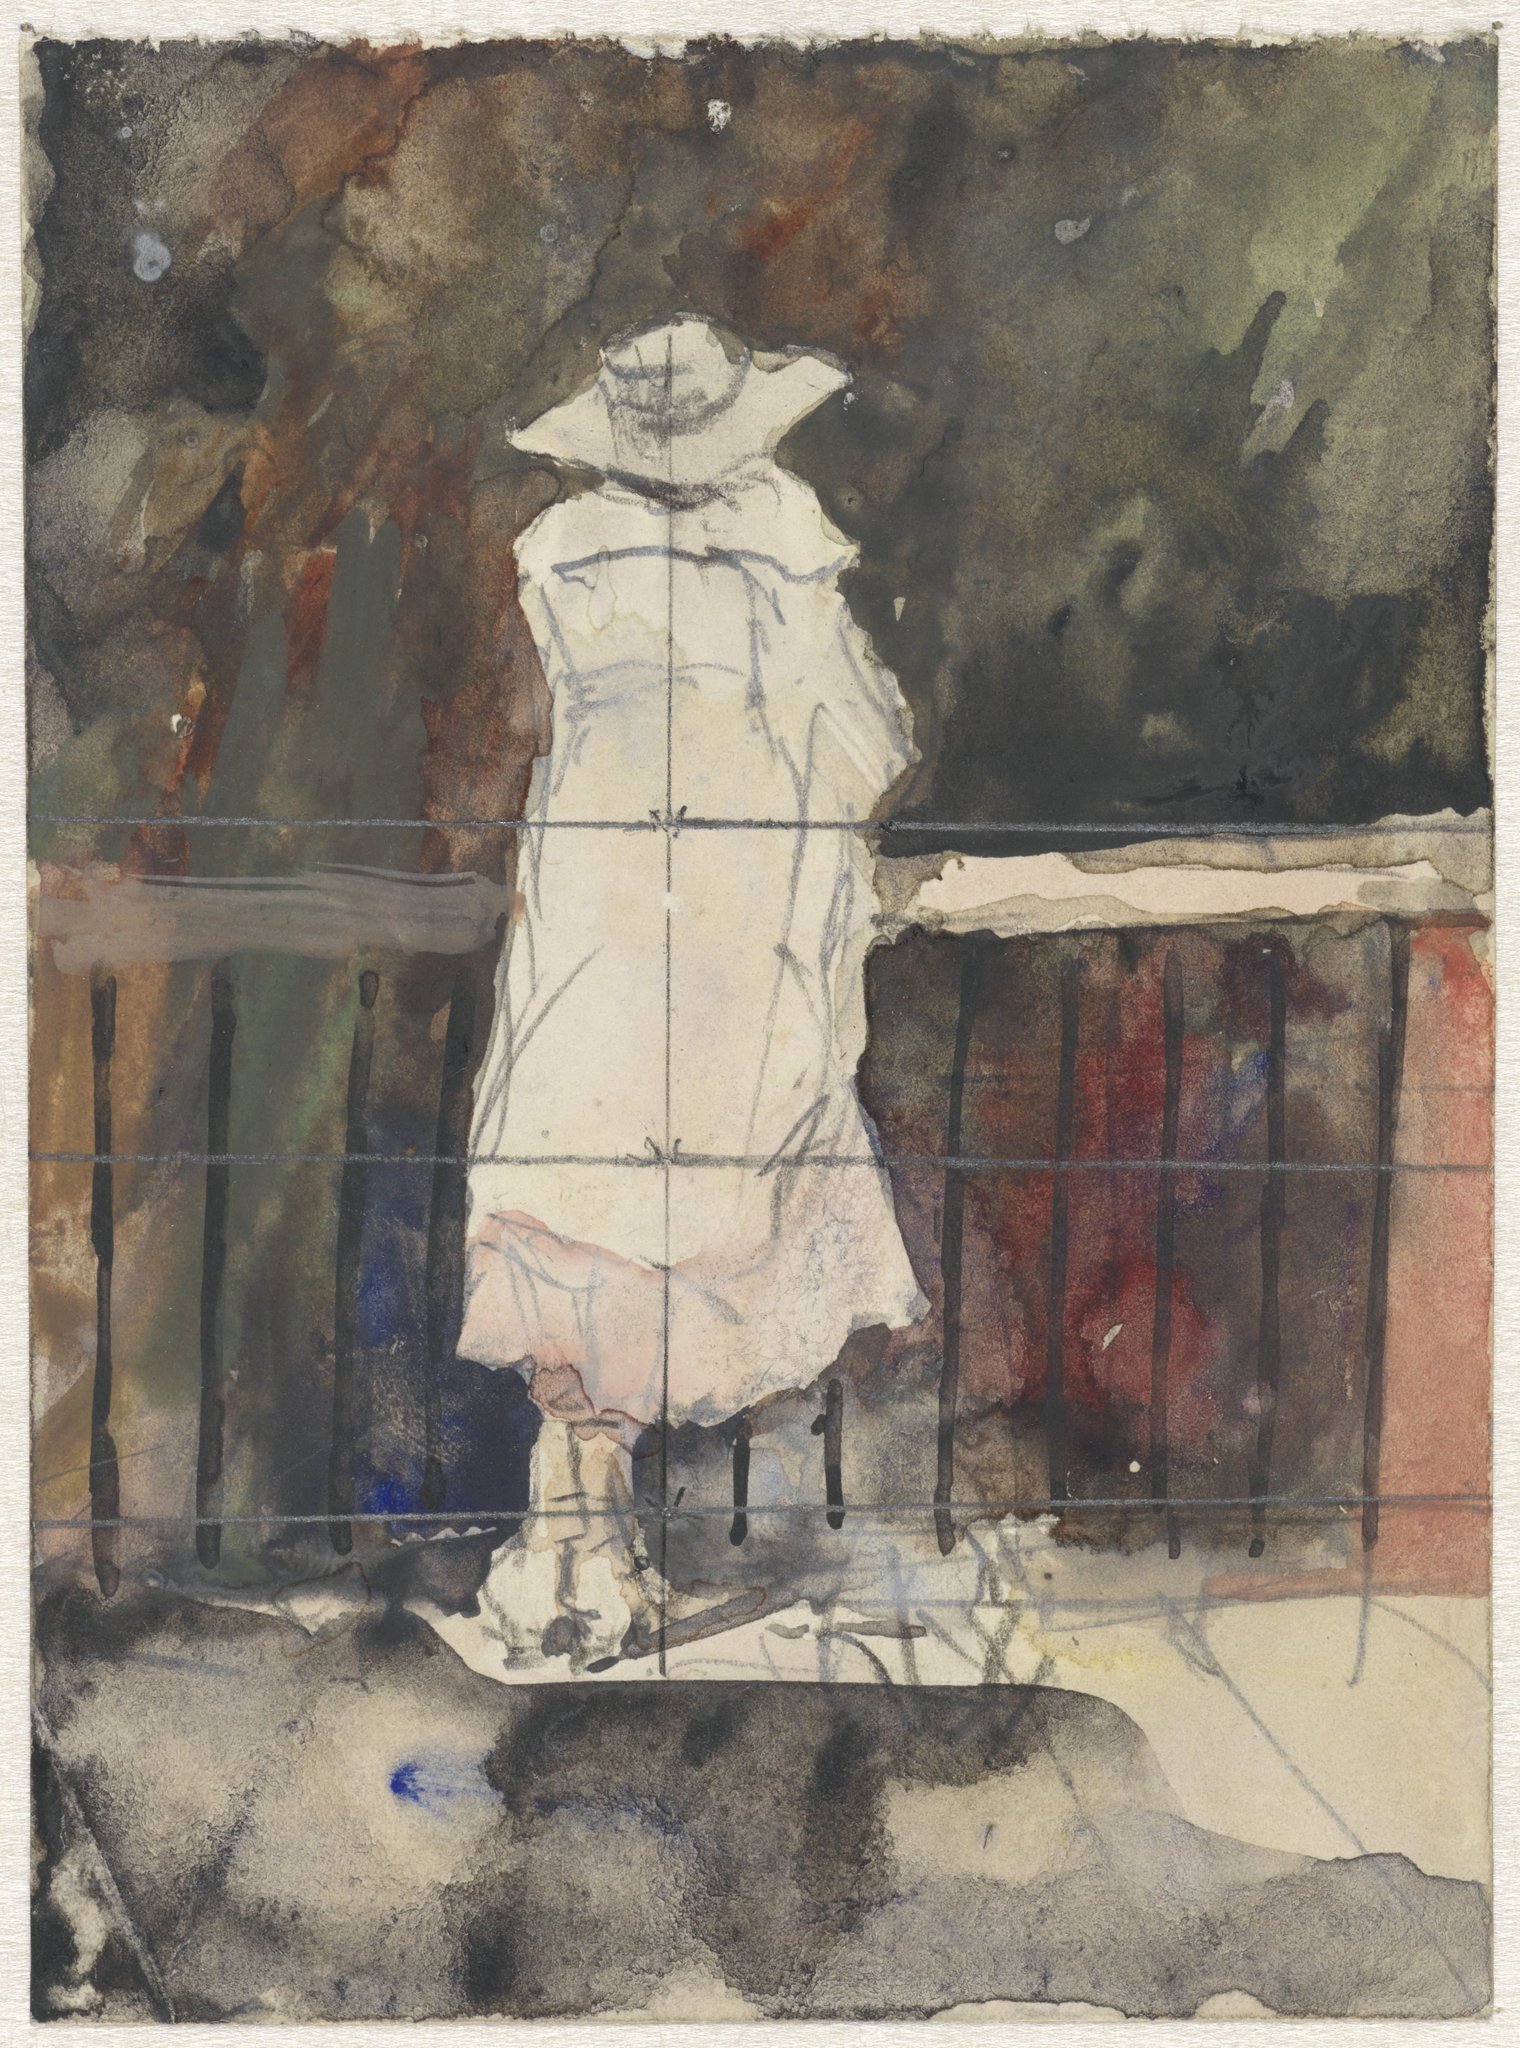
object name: drawing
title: Staande vrouw voor een balustrade, op de rug gezien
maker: adolf le comte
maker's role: draughtsman, painter, print maker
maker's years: 1850-1921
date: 1860-1921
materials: paper, pencil, watercolor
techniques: brush